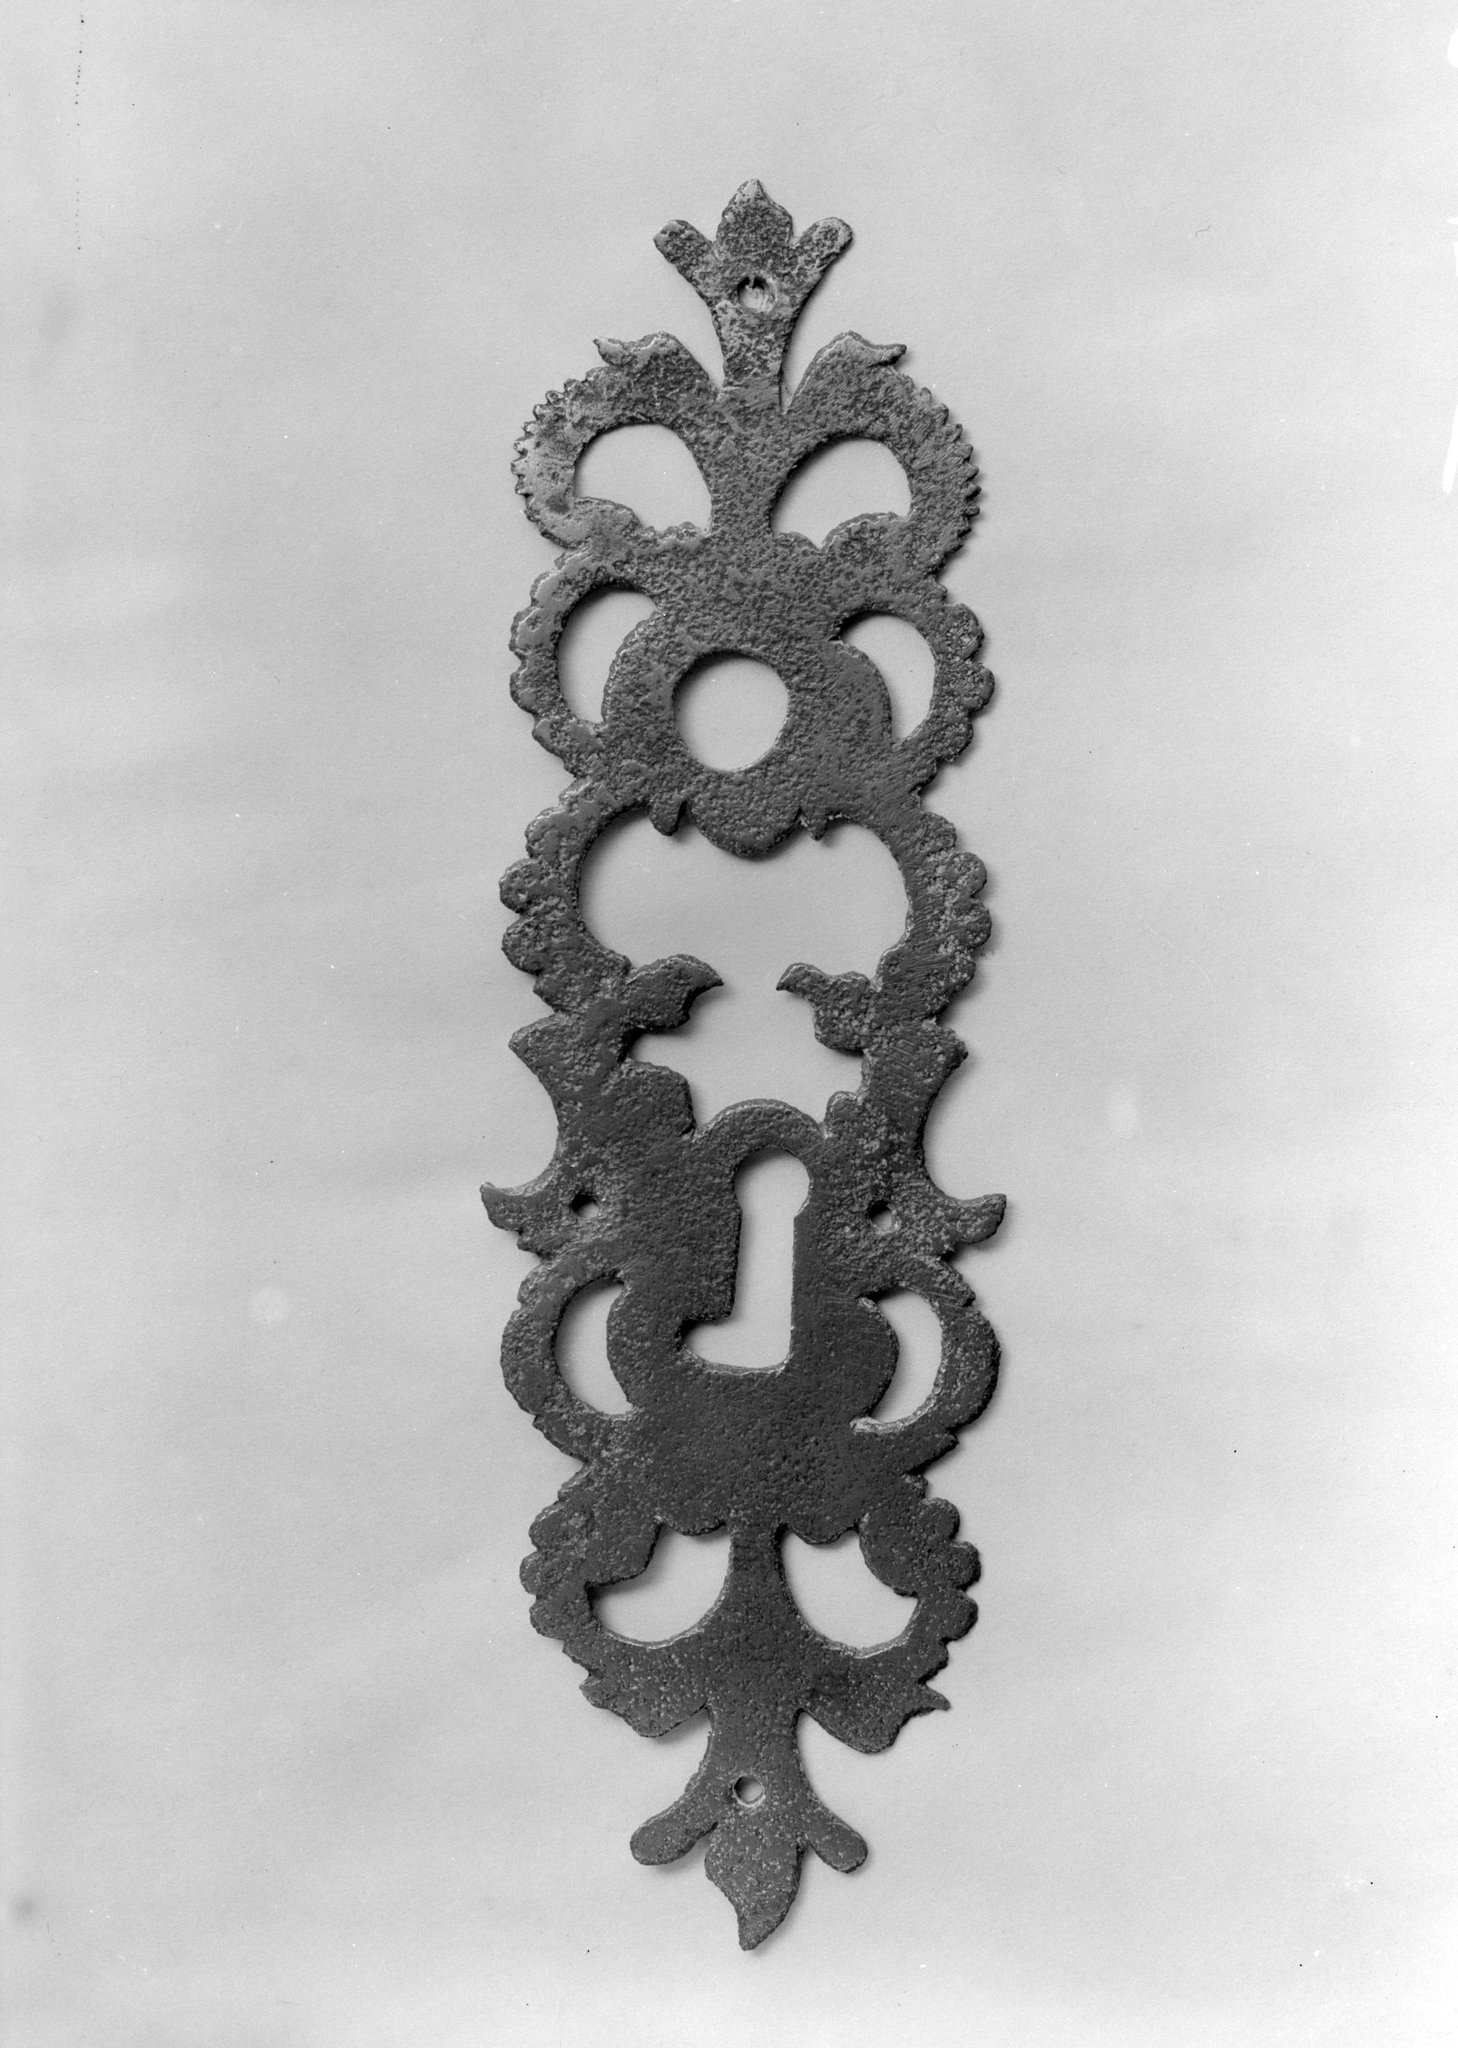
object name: escutcheon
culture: american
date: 1730-1770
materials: iron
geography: united states